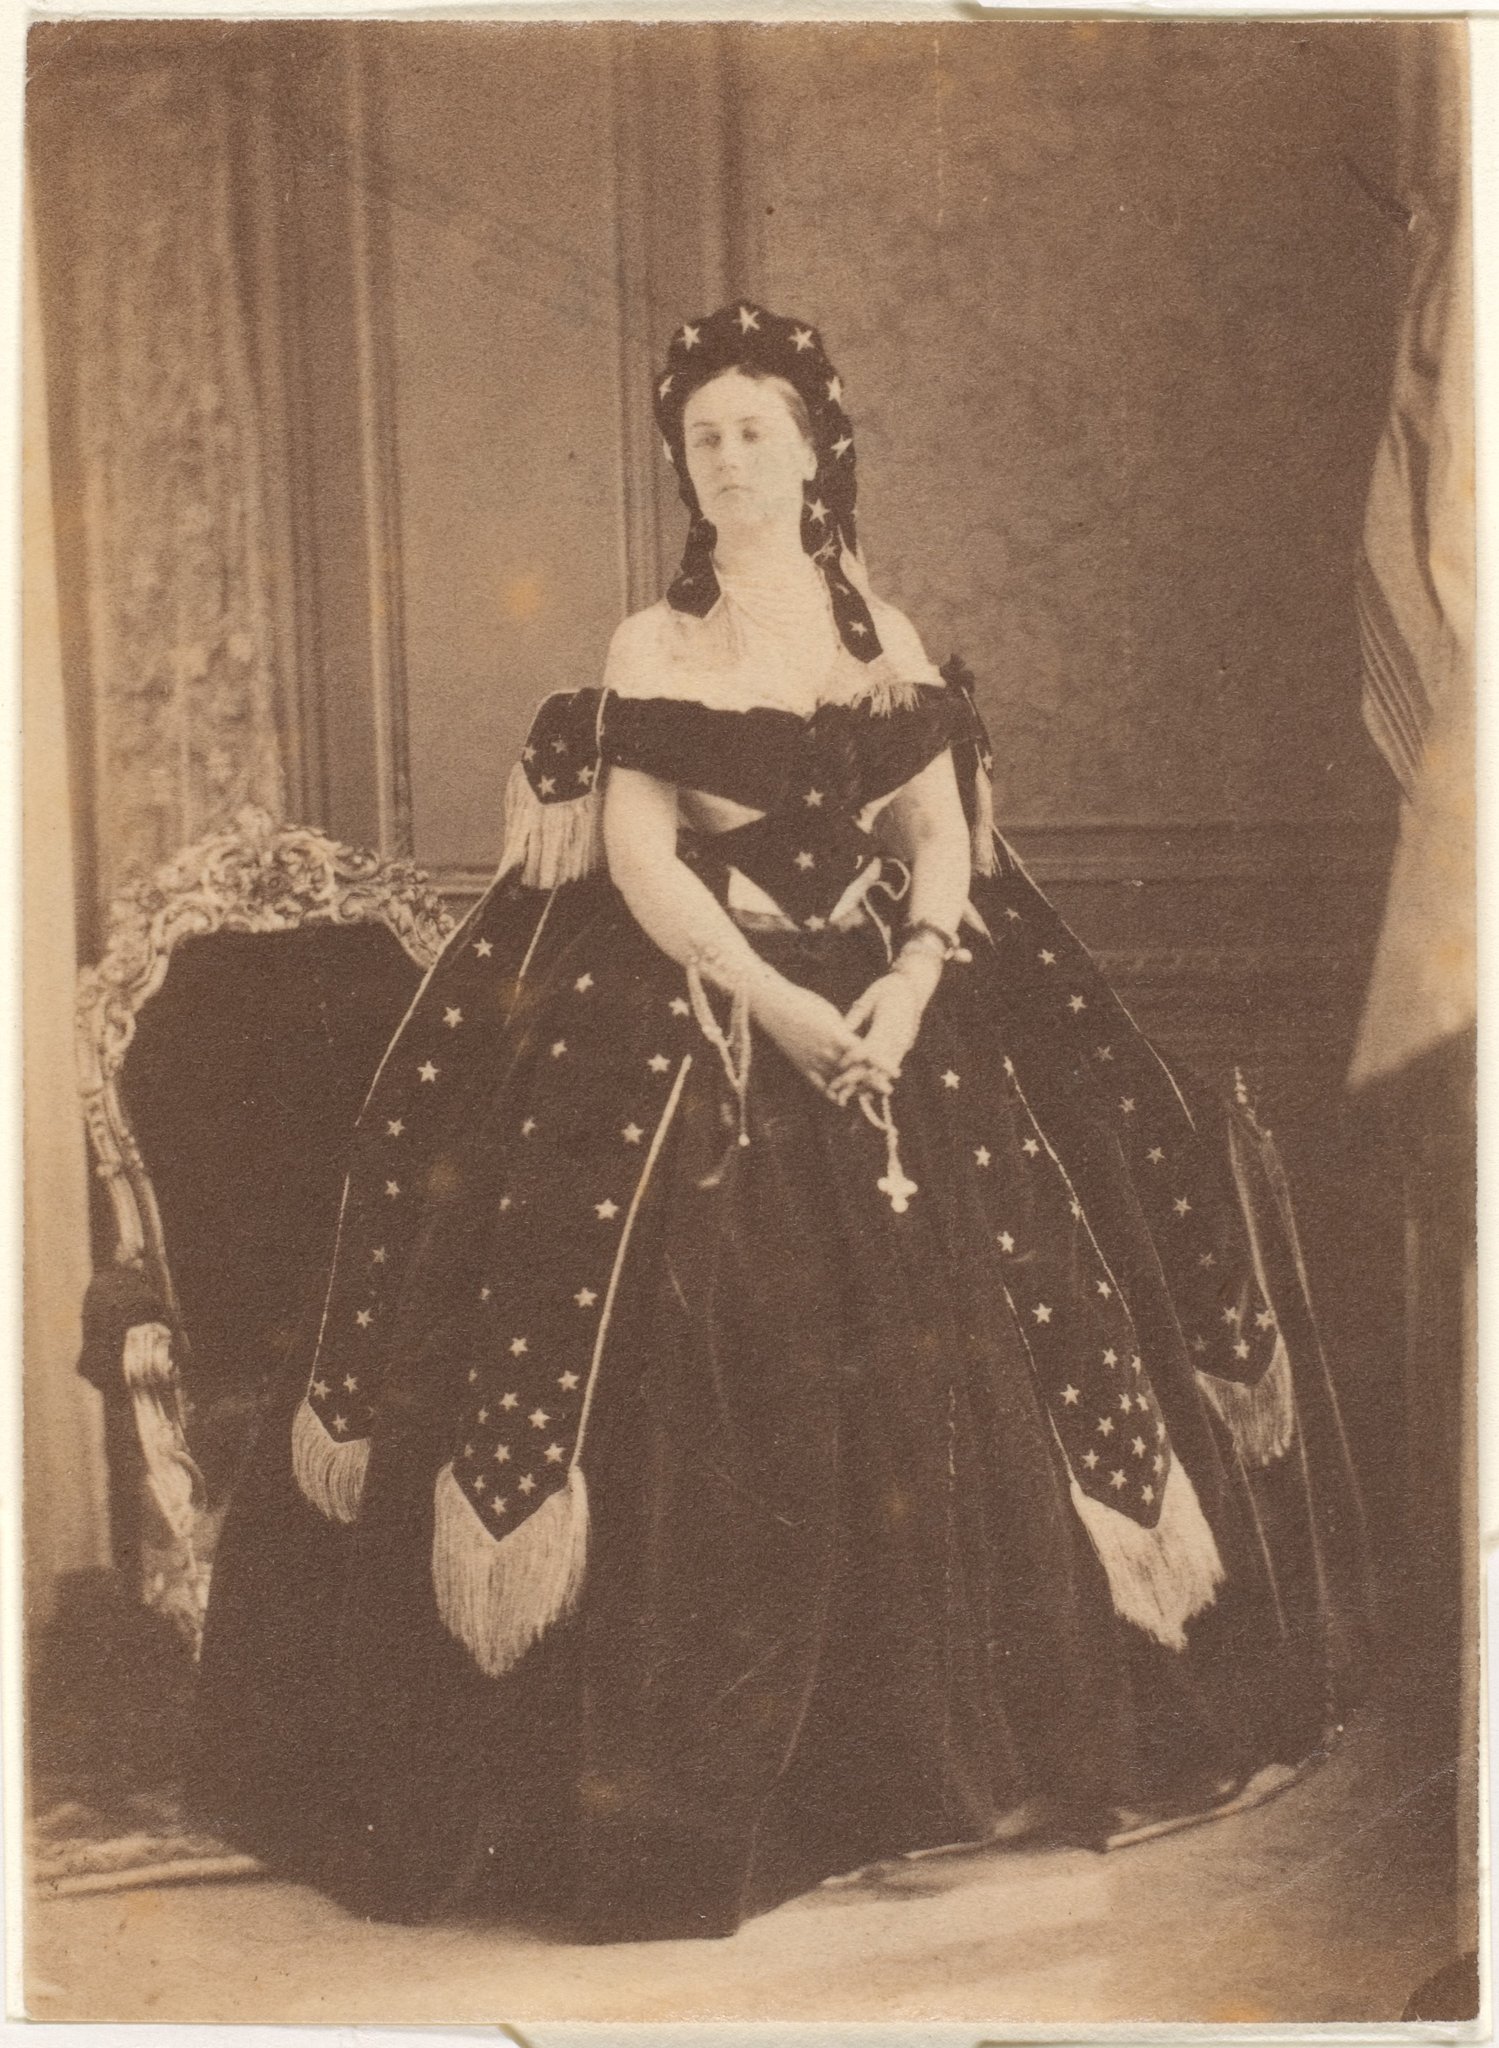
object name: photograph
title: Cauchoise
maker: pierre-louis pierson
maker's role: artist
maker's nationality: french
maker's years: 1822-1913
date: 1860-1869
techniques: albumen silver print, glass negative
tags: portraits,women